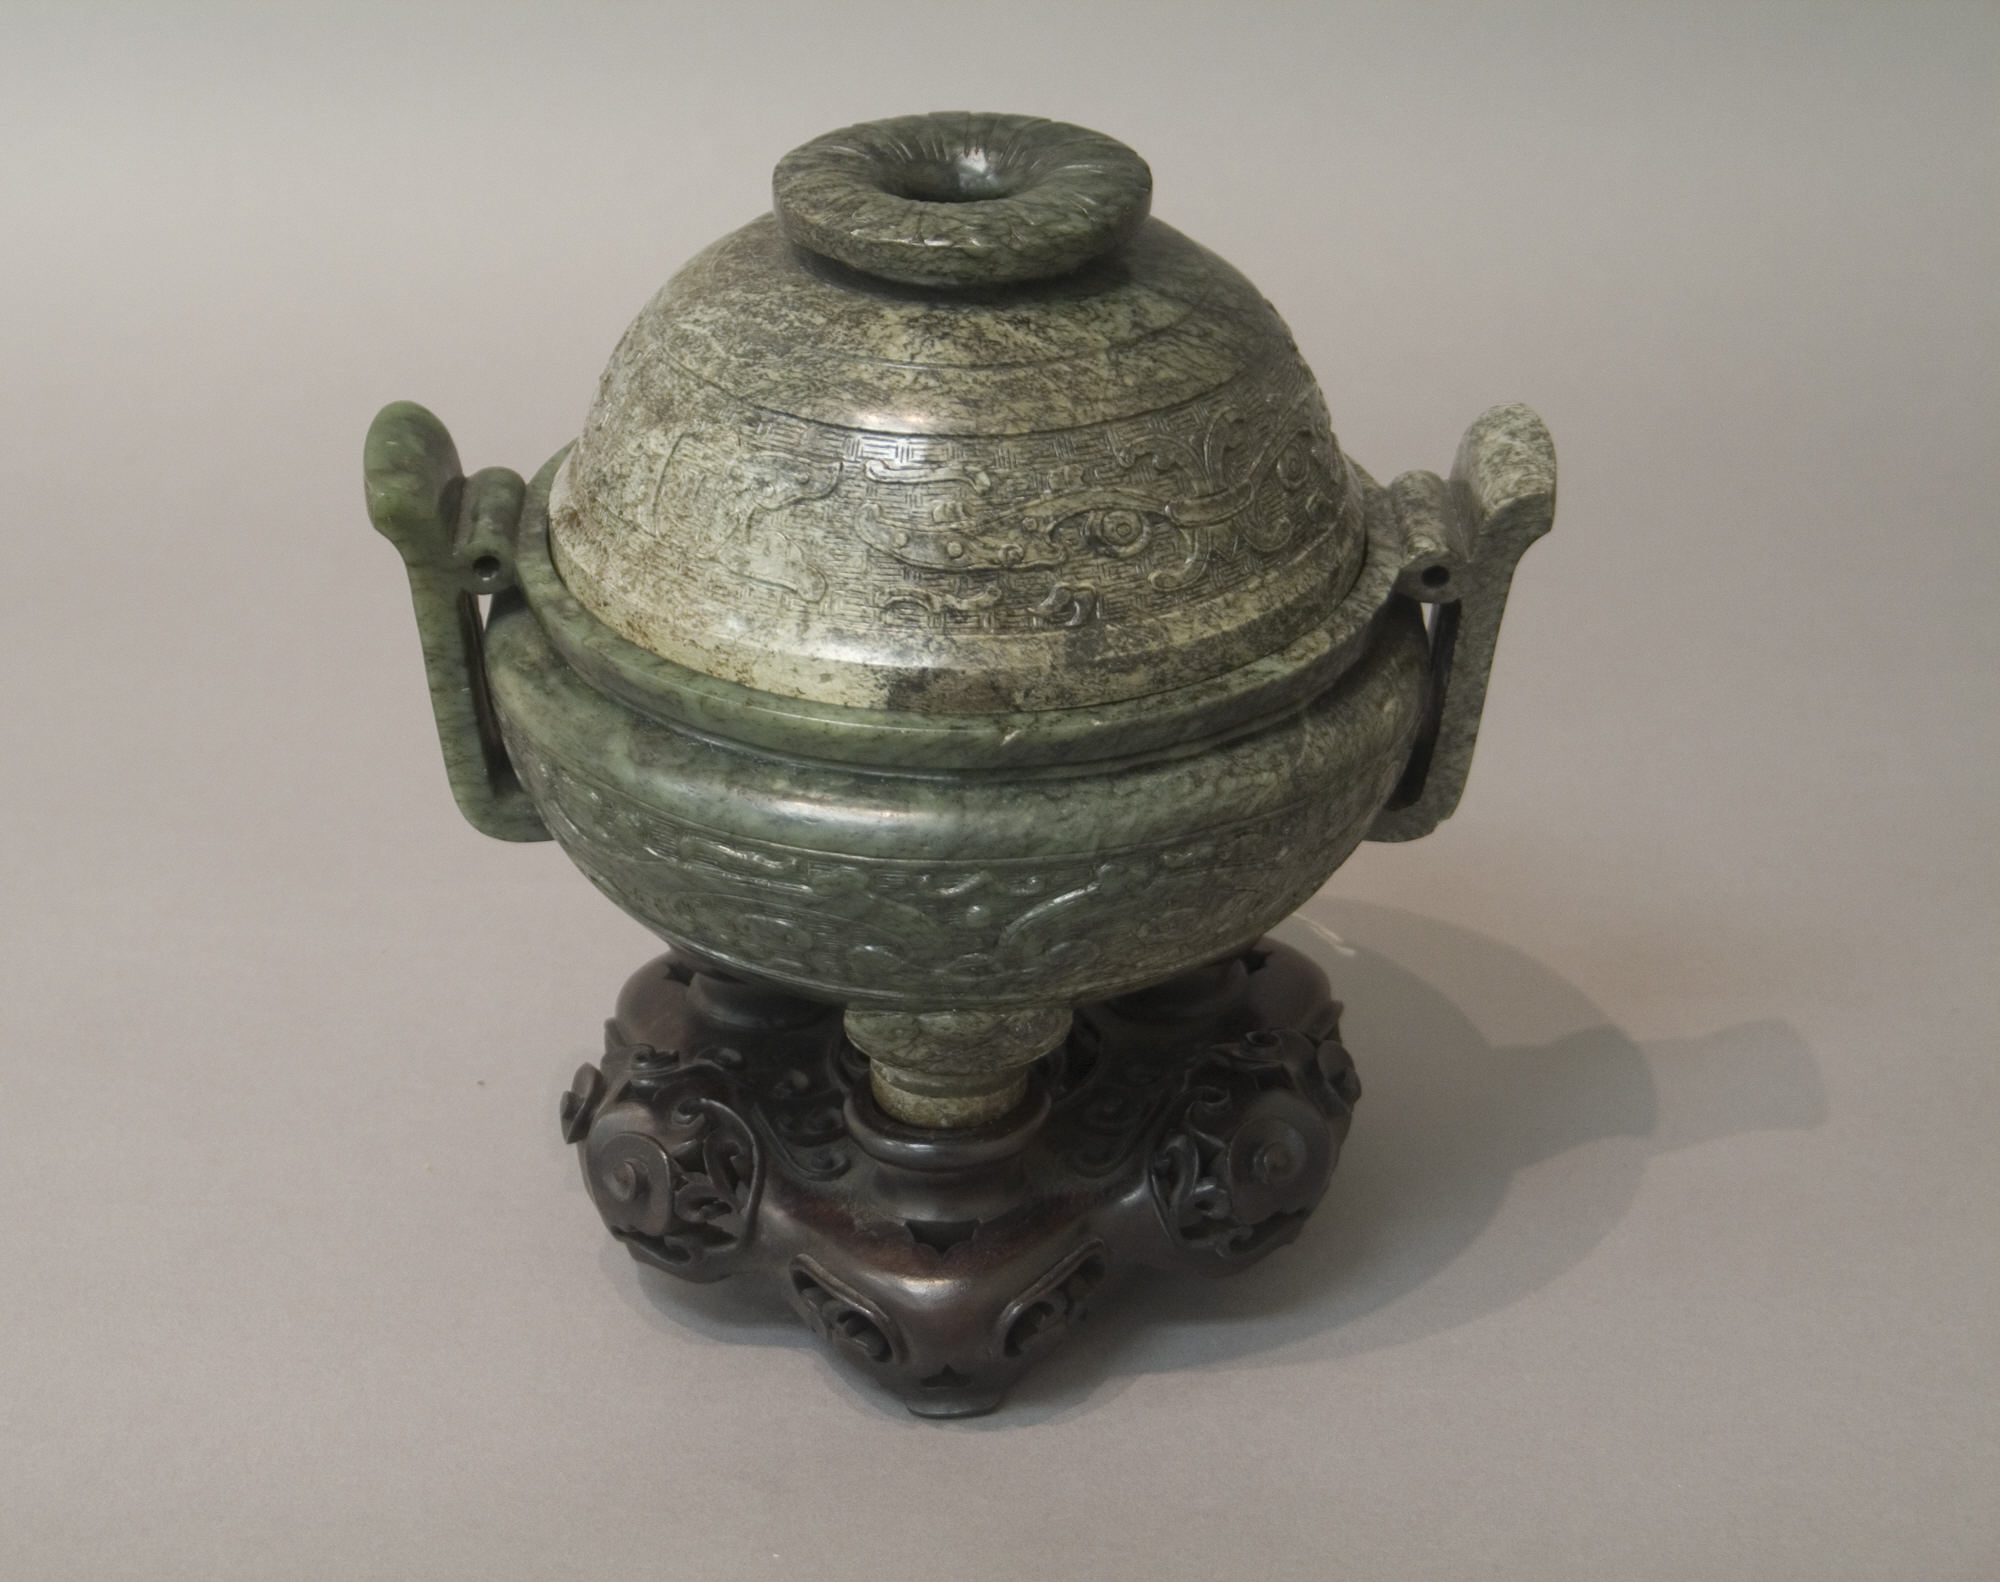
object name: incense burner with cover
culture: chinese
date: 1368-1644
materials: wood, jade